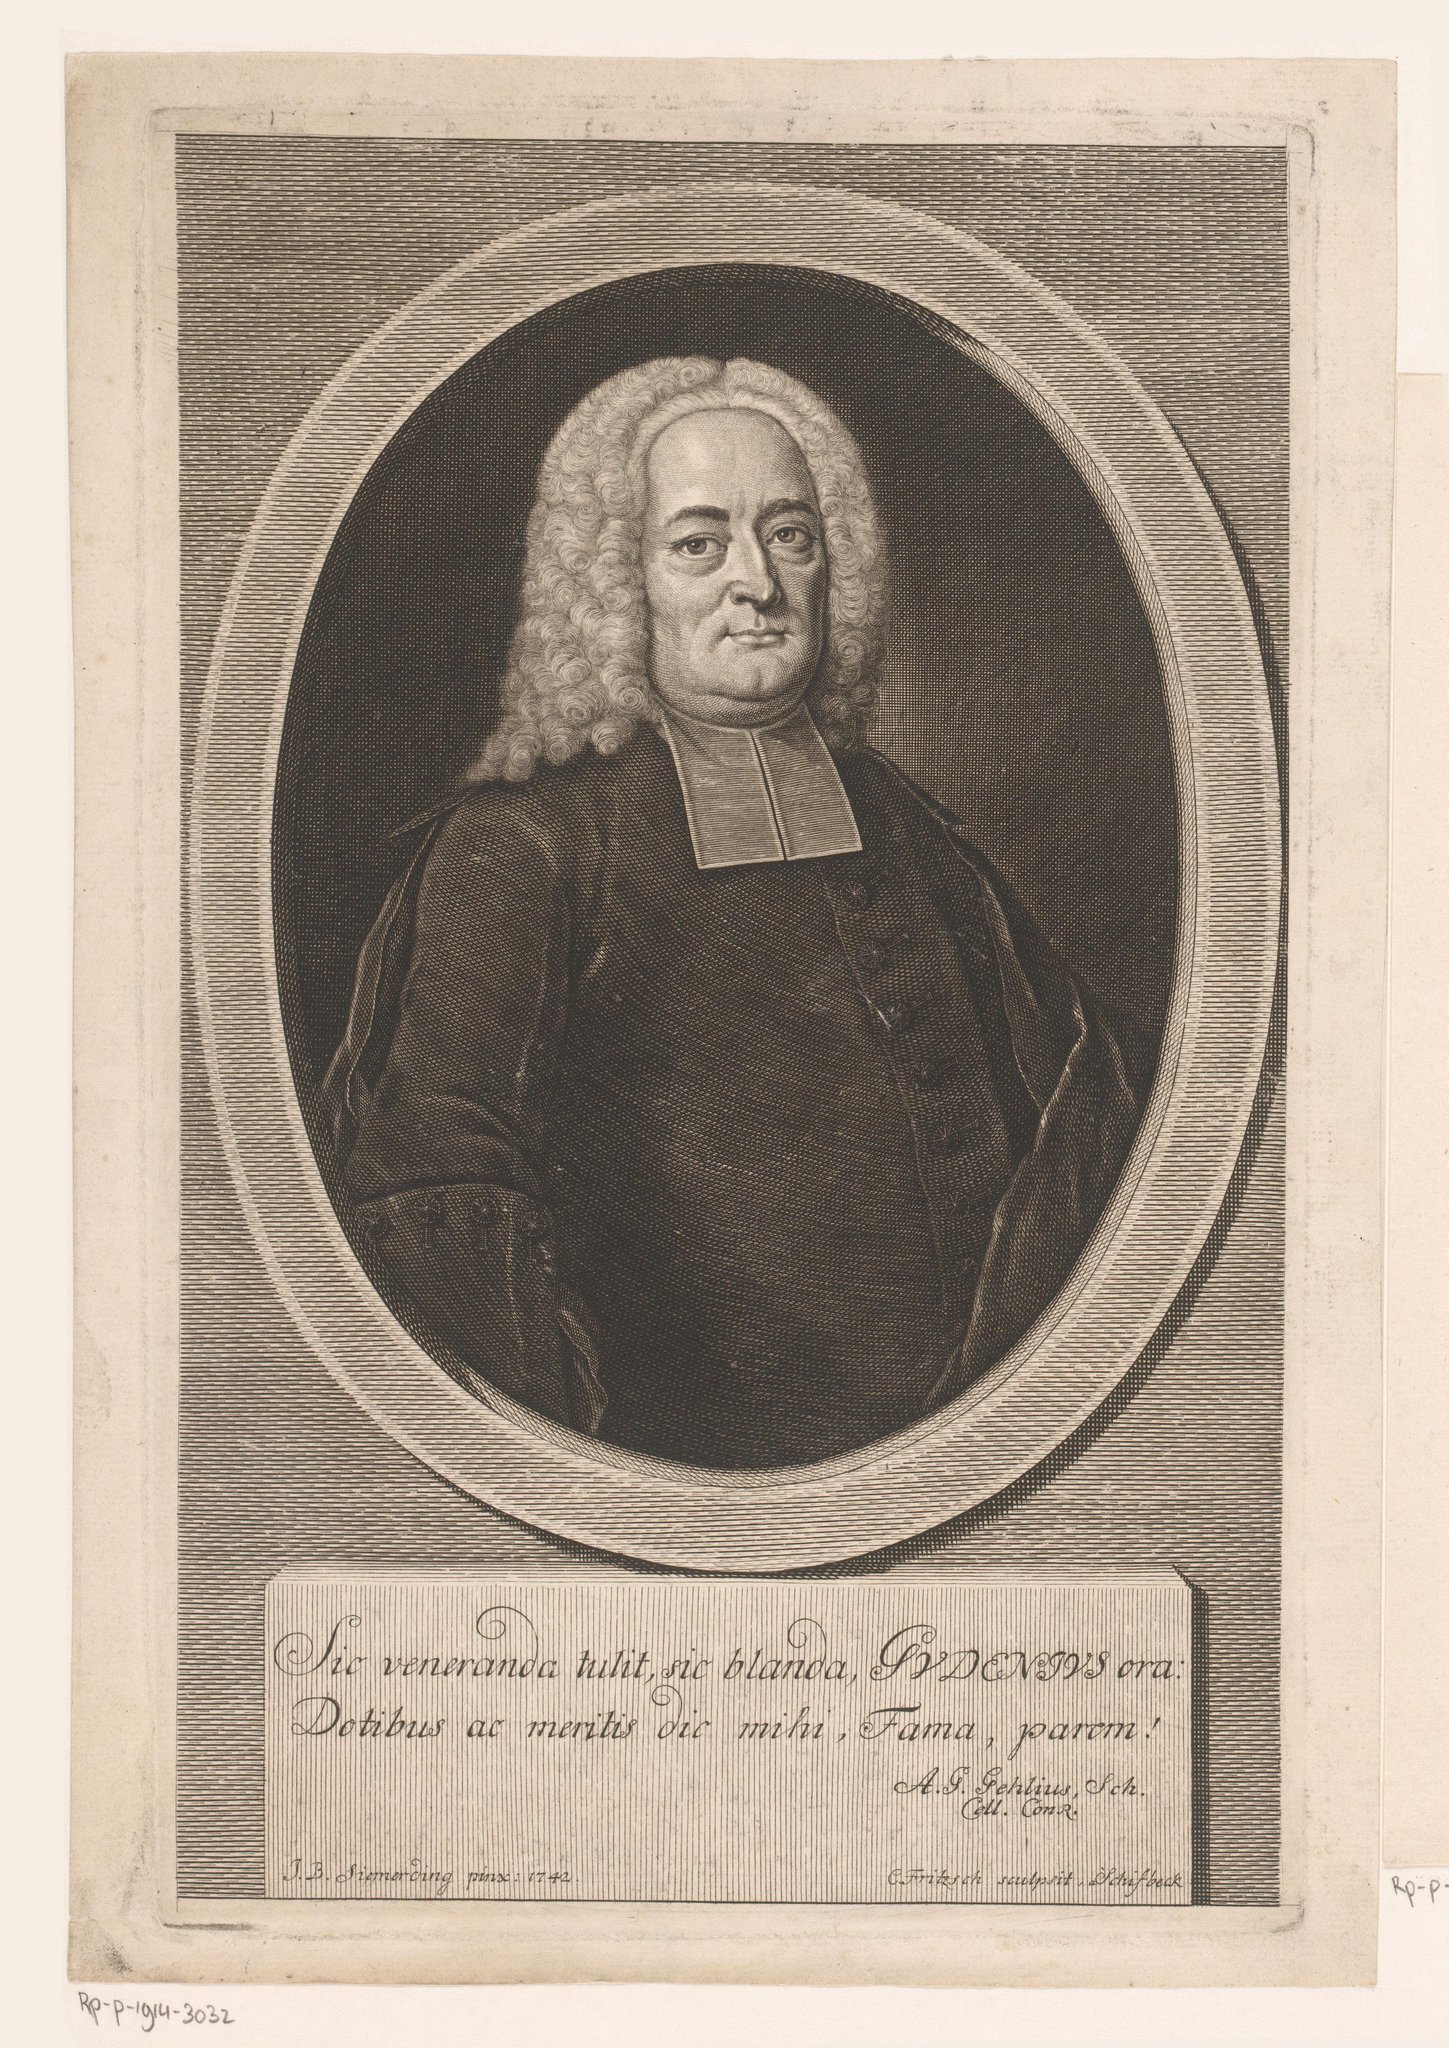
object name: print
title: Portret van Heinrich Philipp Guden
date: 1742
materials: paper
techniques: engraving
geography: schiffbeck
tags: historical persons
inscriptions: collector's mark: Lugt 2228